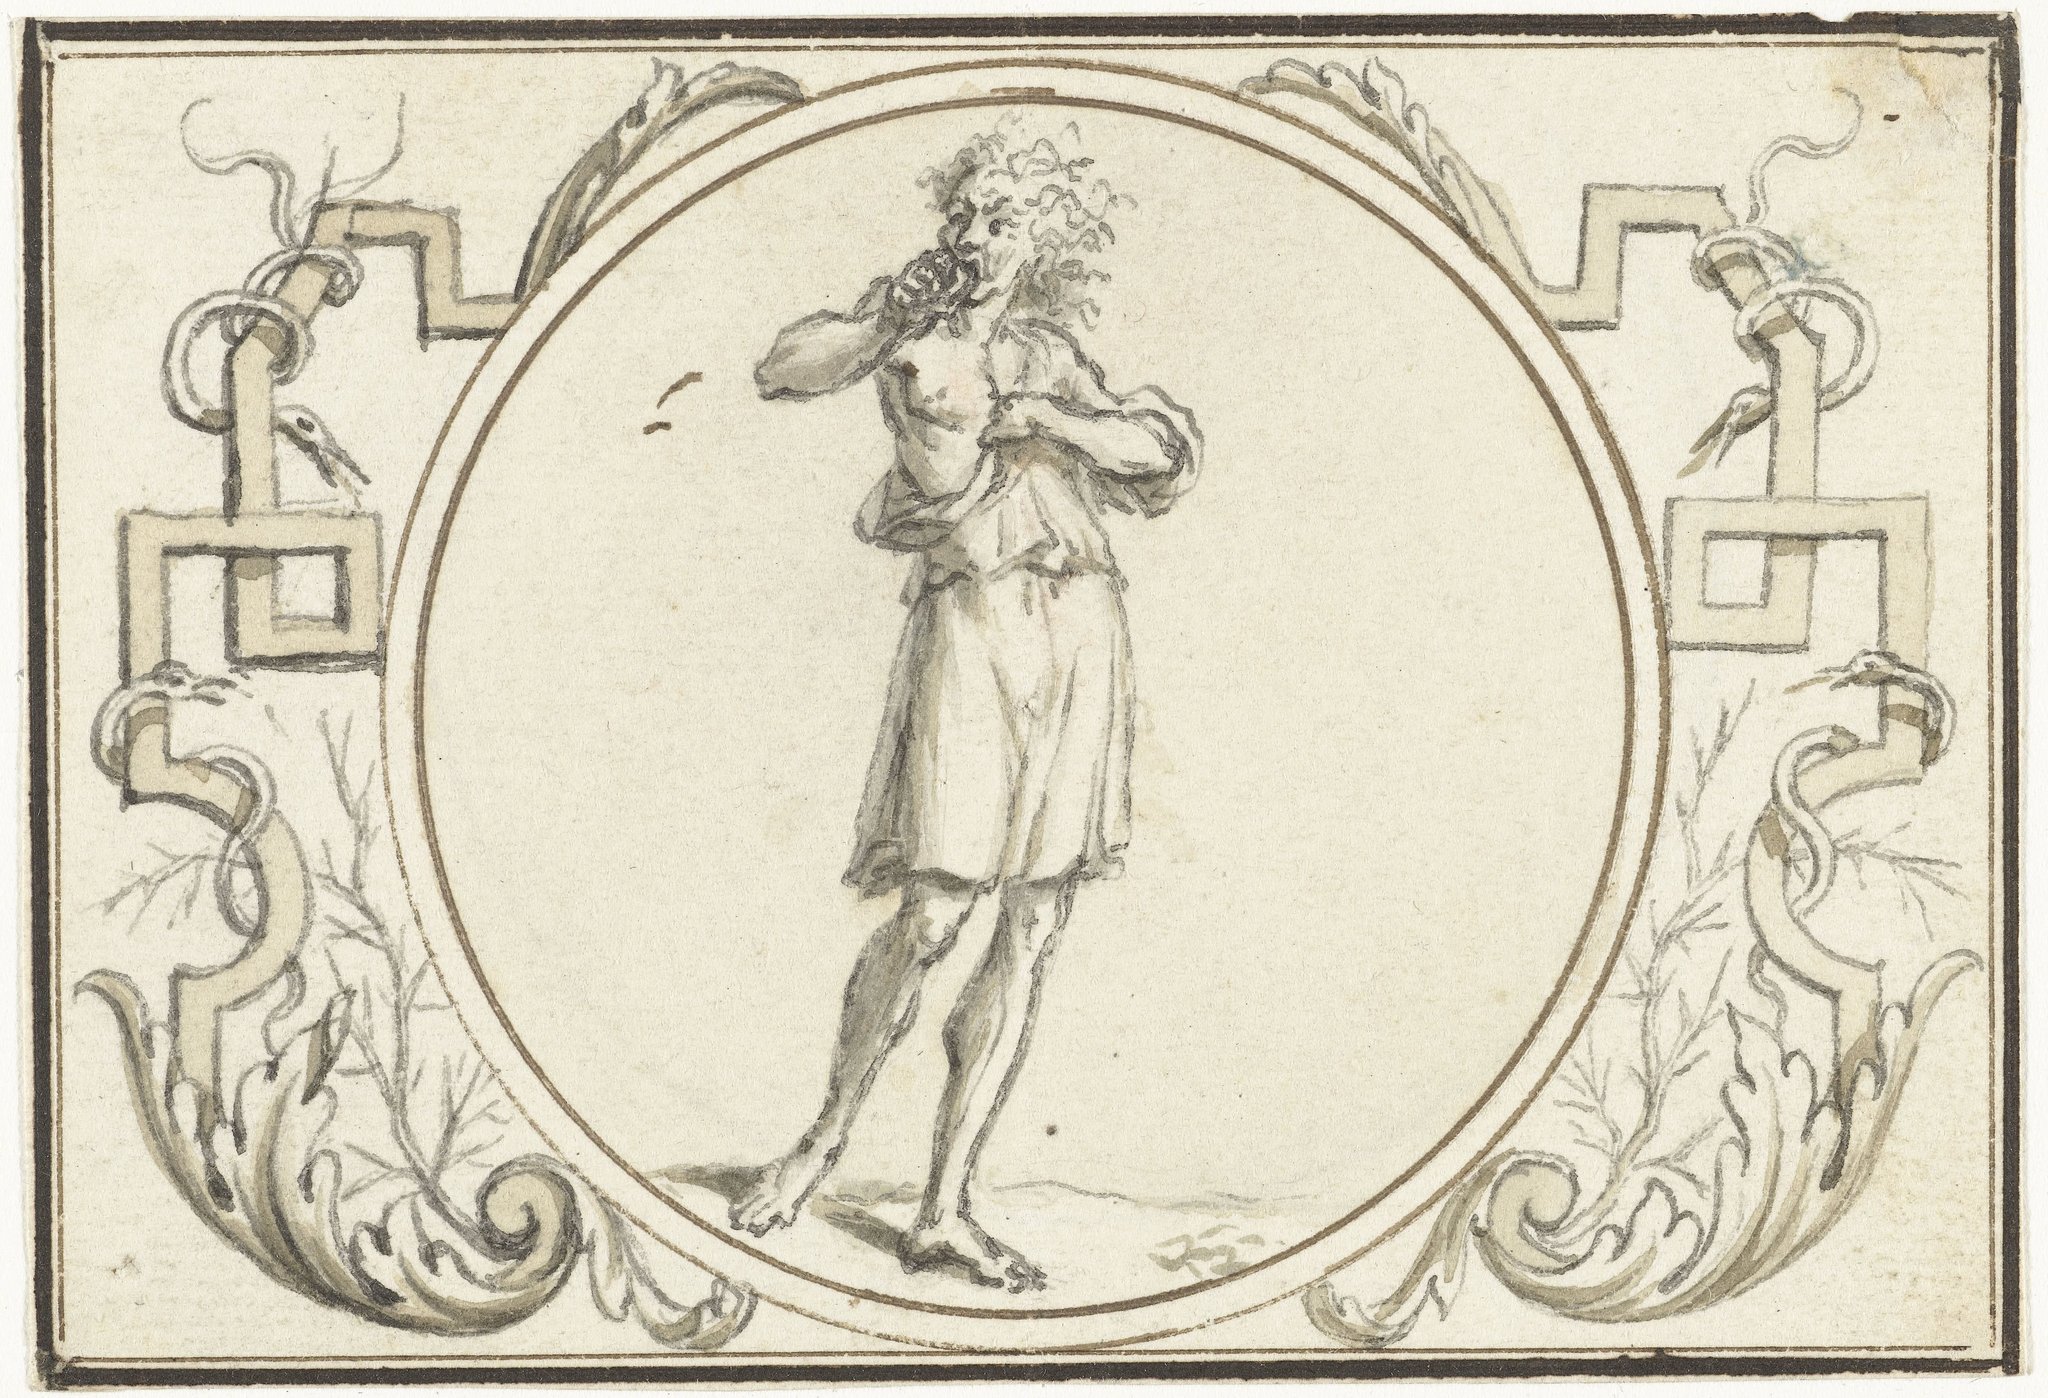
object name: design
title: Invidia in een medaillon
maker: frederik ottens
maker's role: draughtsman, print maker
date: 1700-1749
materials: ink, paper, pencil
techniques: brush, pen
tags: envy; 'invidia' (ripa) ~ personification of one of the seven deadly sins